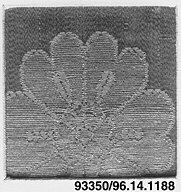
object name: piece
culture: japanese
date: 1701-1900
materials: silk